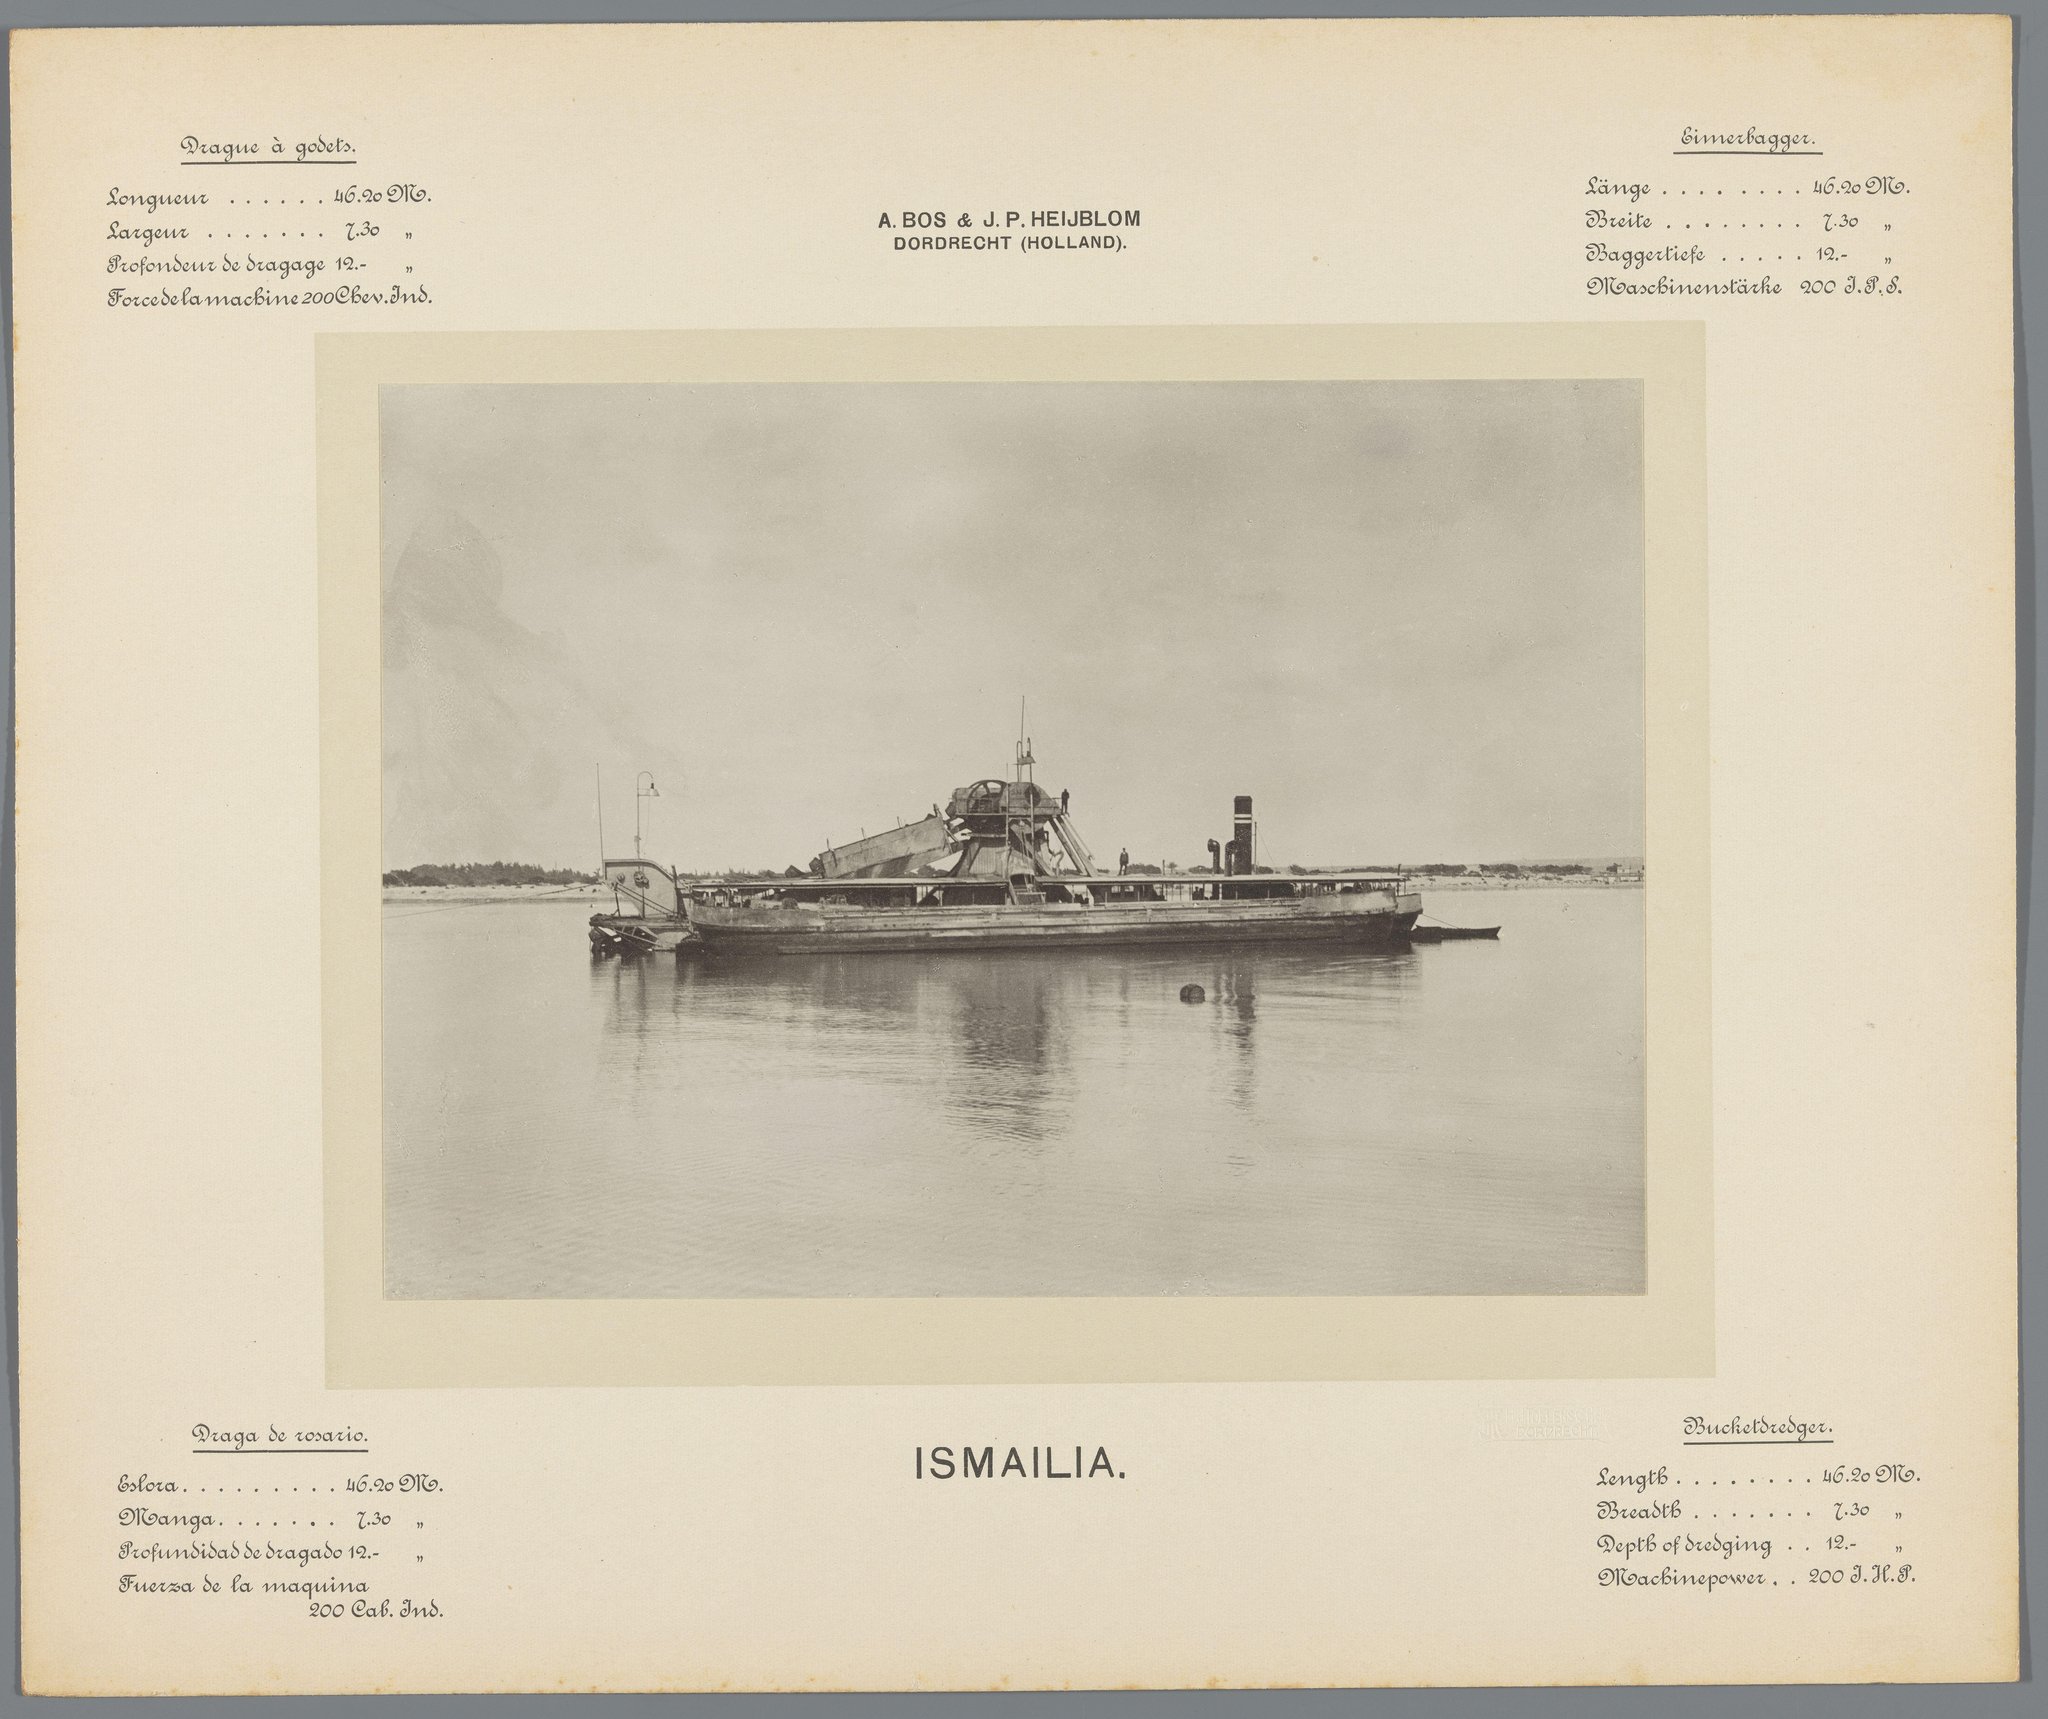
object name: photograph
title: Ismailia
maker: henricus jacobus tollens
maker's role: painter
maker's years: 1864-1936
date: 1900-1910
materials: cardboard, photographic support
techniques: gelatin silver print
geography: dordrecht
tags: machine driven by steam, steamship, motorship (+ propulsion of vehicle, ship, etc. by steam), dredge, dredging machine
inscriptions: name: ‘H.J. Tollens C. Hzn. Dordrecht’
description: Emmerbaggermolen Ismailia. Foto geplakt op karton met technische informatie over het schip in Duits, Frans, Spaans en Engels. Onderdeel van de map met 44 foto's van baggerschepen van de firma A. Bos & J.P. Heijblom te Dordrecht.